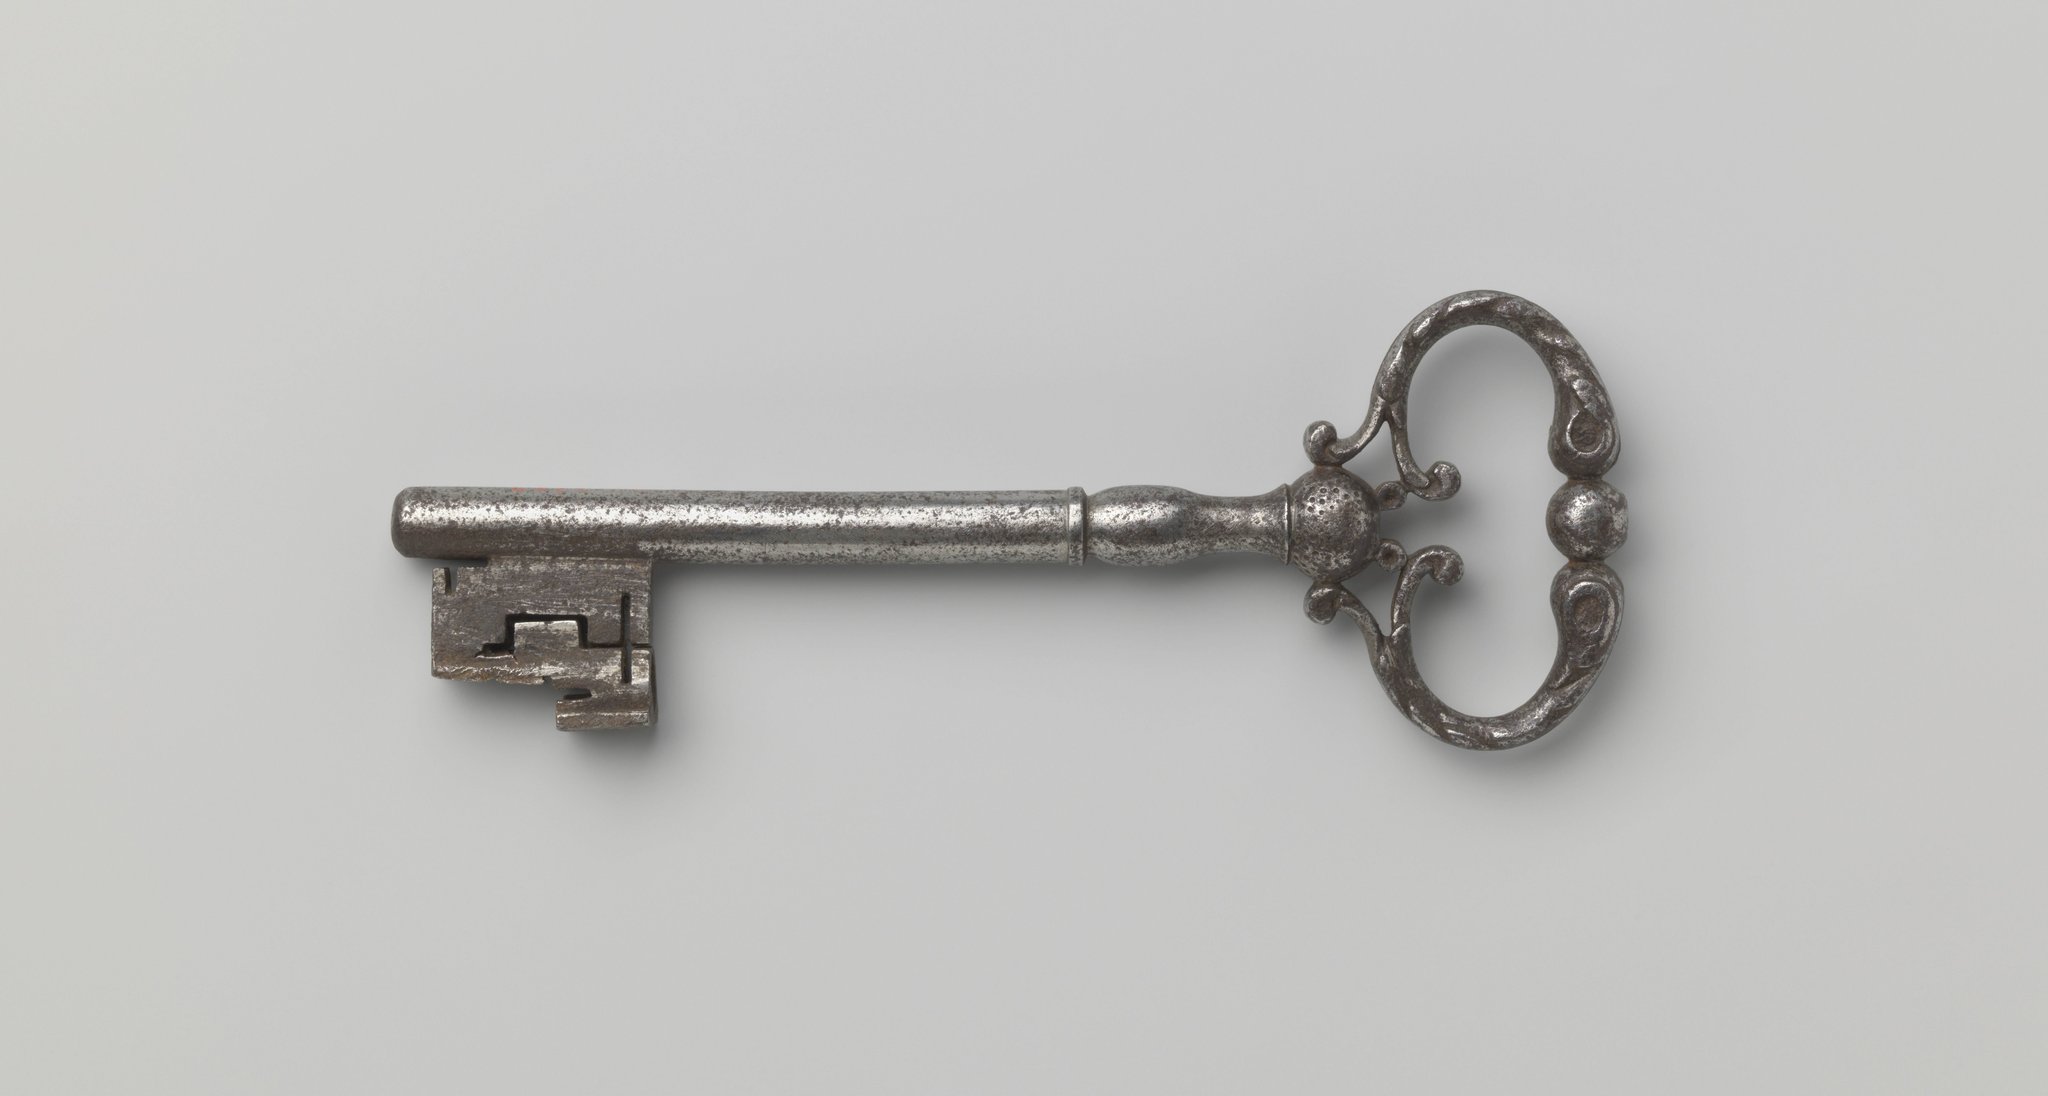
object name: key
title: Sleutel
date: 1600-1699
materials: iron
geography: france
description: Sleutel waarvan de schacht bovenaan vaasvormig verloopt en overgaat in een getande kogel. Hieraan is de greep bevestigd, bestaande uit twee C-vormige bladvoluten, boven verbonden door een kogeltje en onderaan zich splitsend. Baard geschonden.